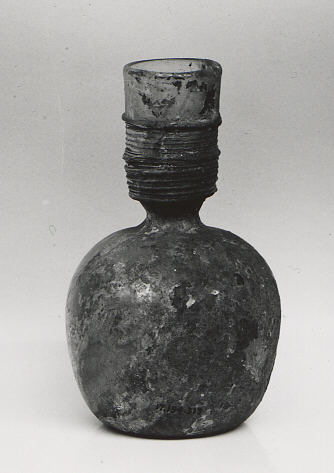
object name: bottle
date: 401-600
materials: glass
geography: syria